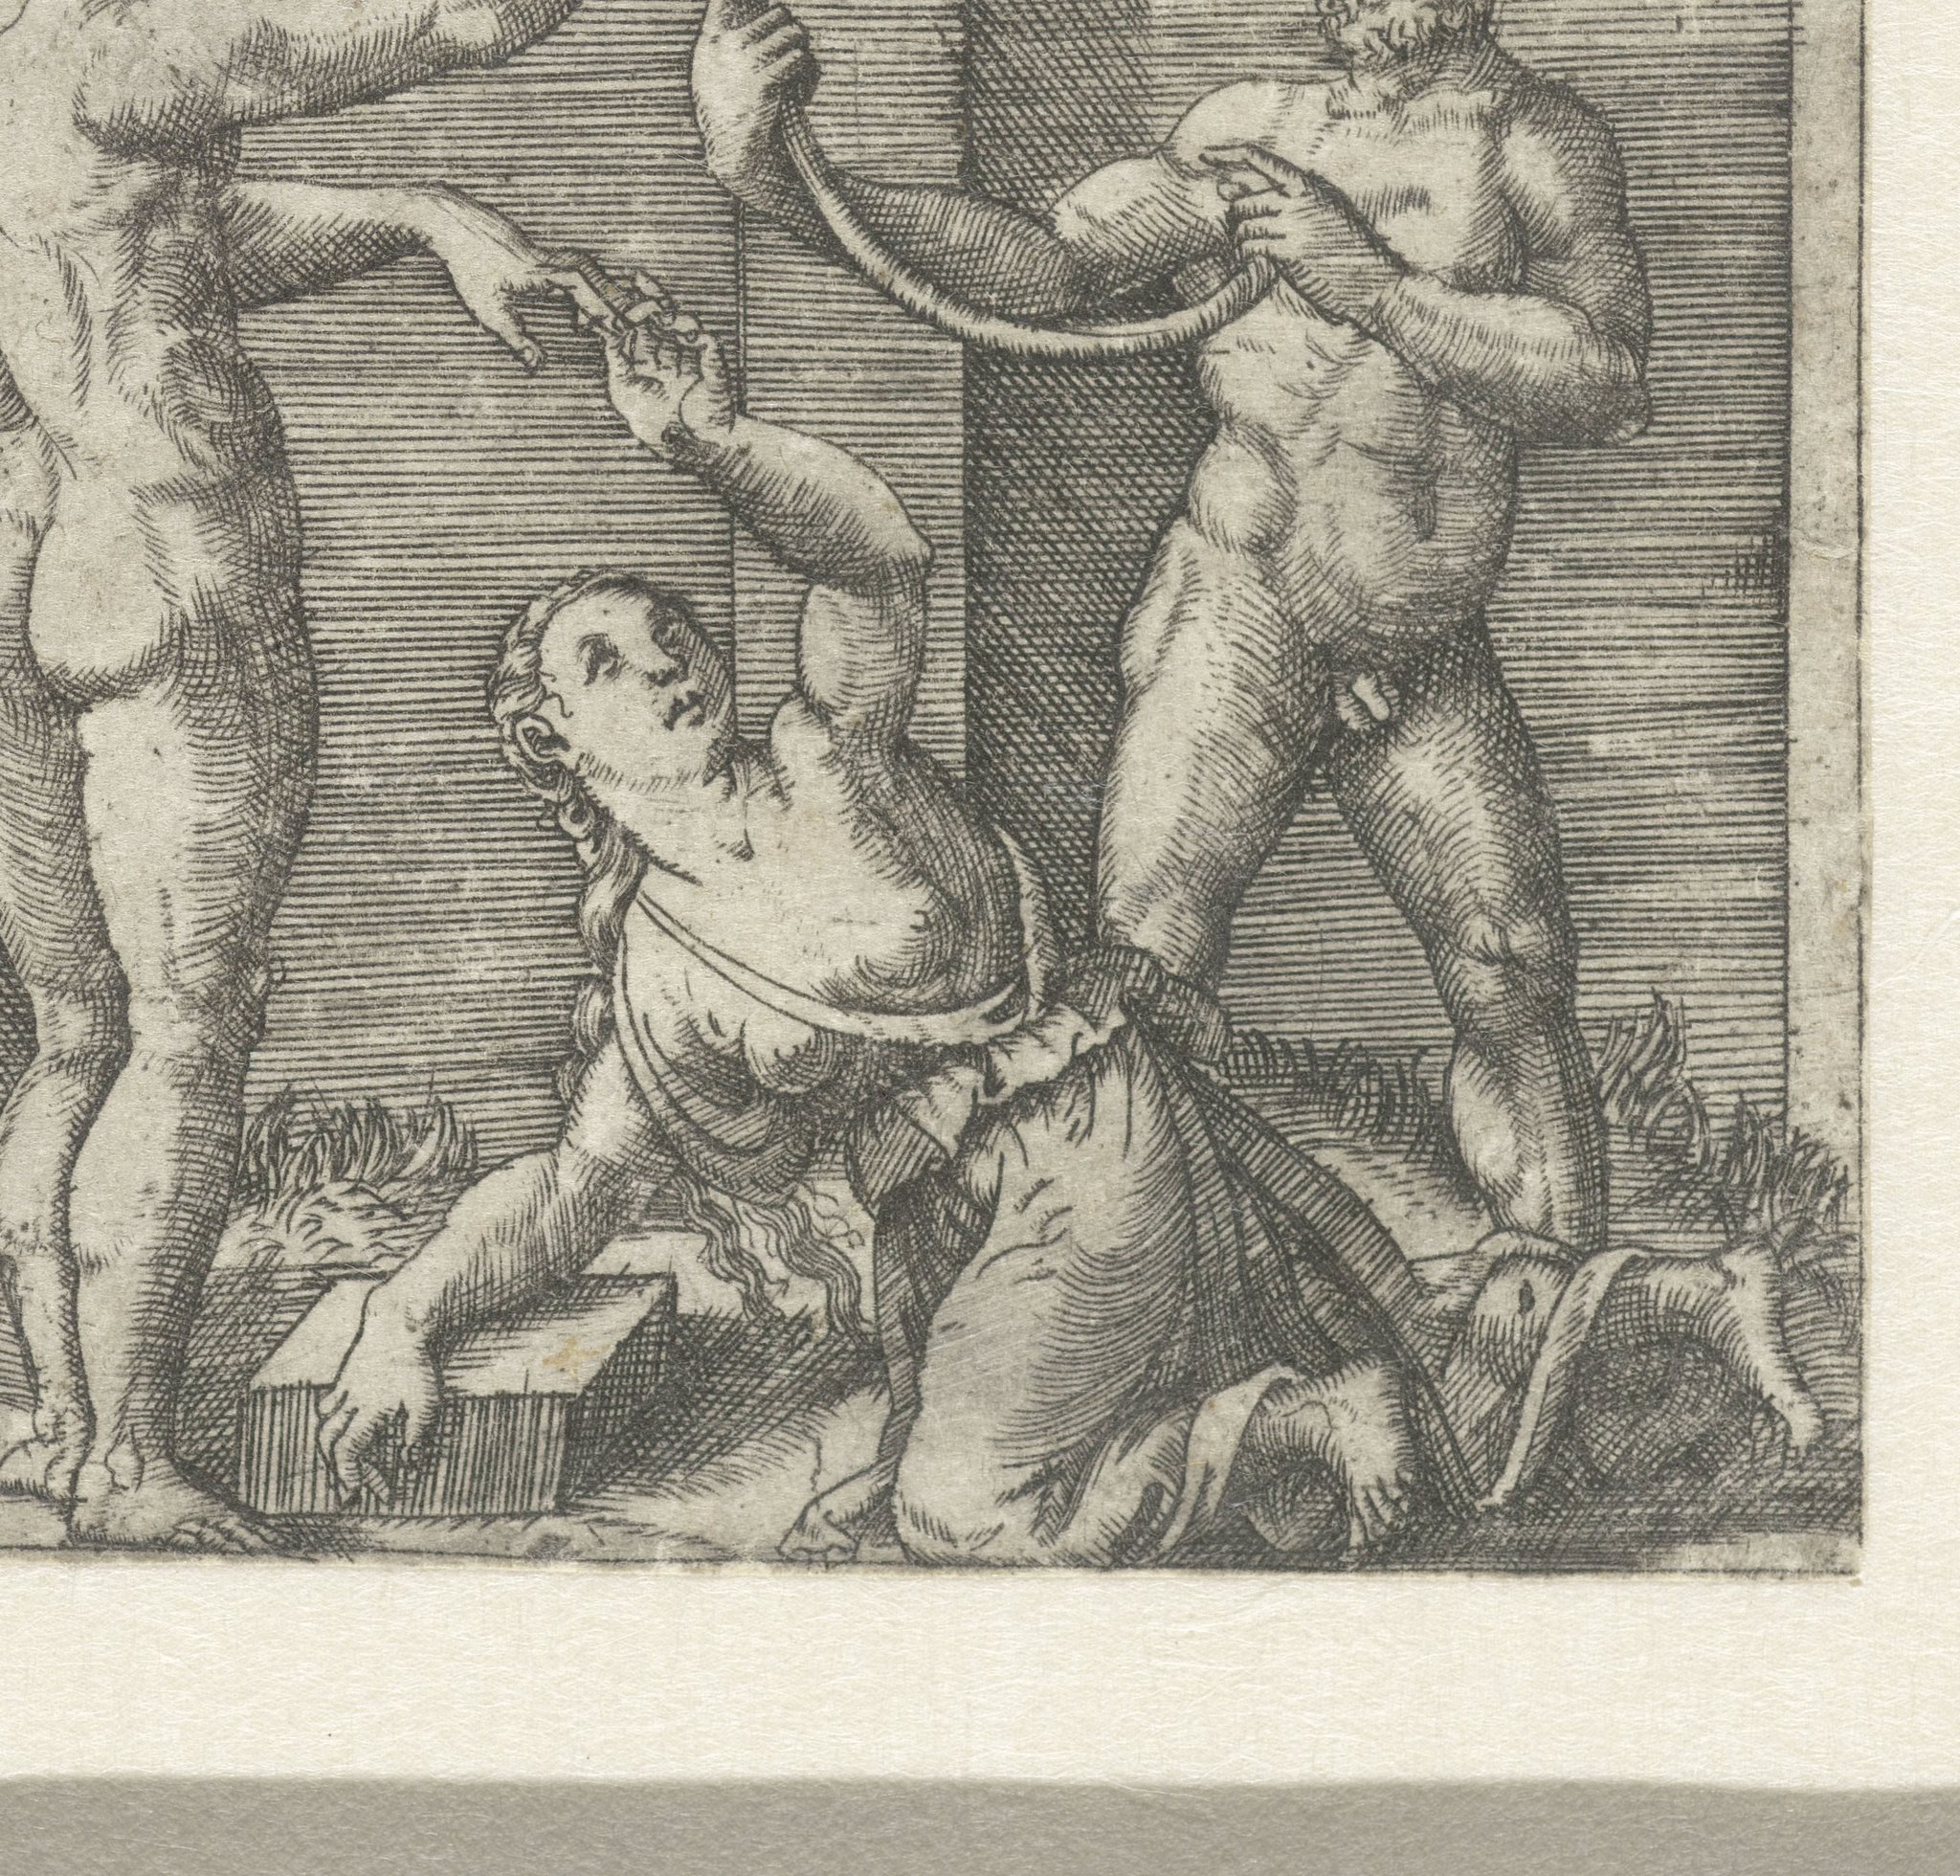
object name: print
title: Twee mannen buigen staaf krom en vrouw schuift ring aan vinger man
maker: Anonymous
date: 1510-1575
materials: paper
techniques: engraving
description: Kopie in spiegelbeeld naar prent van Marcantonio Raimondi. Raimondi baseerde zich op een ontwerp van Francesco Francia.